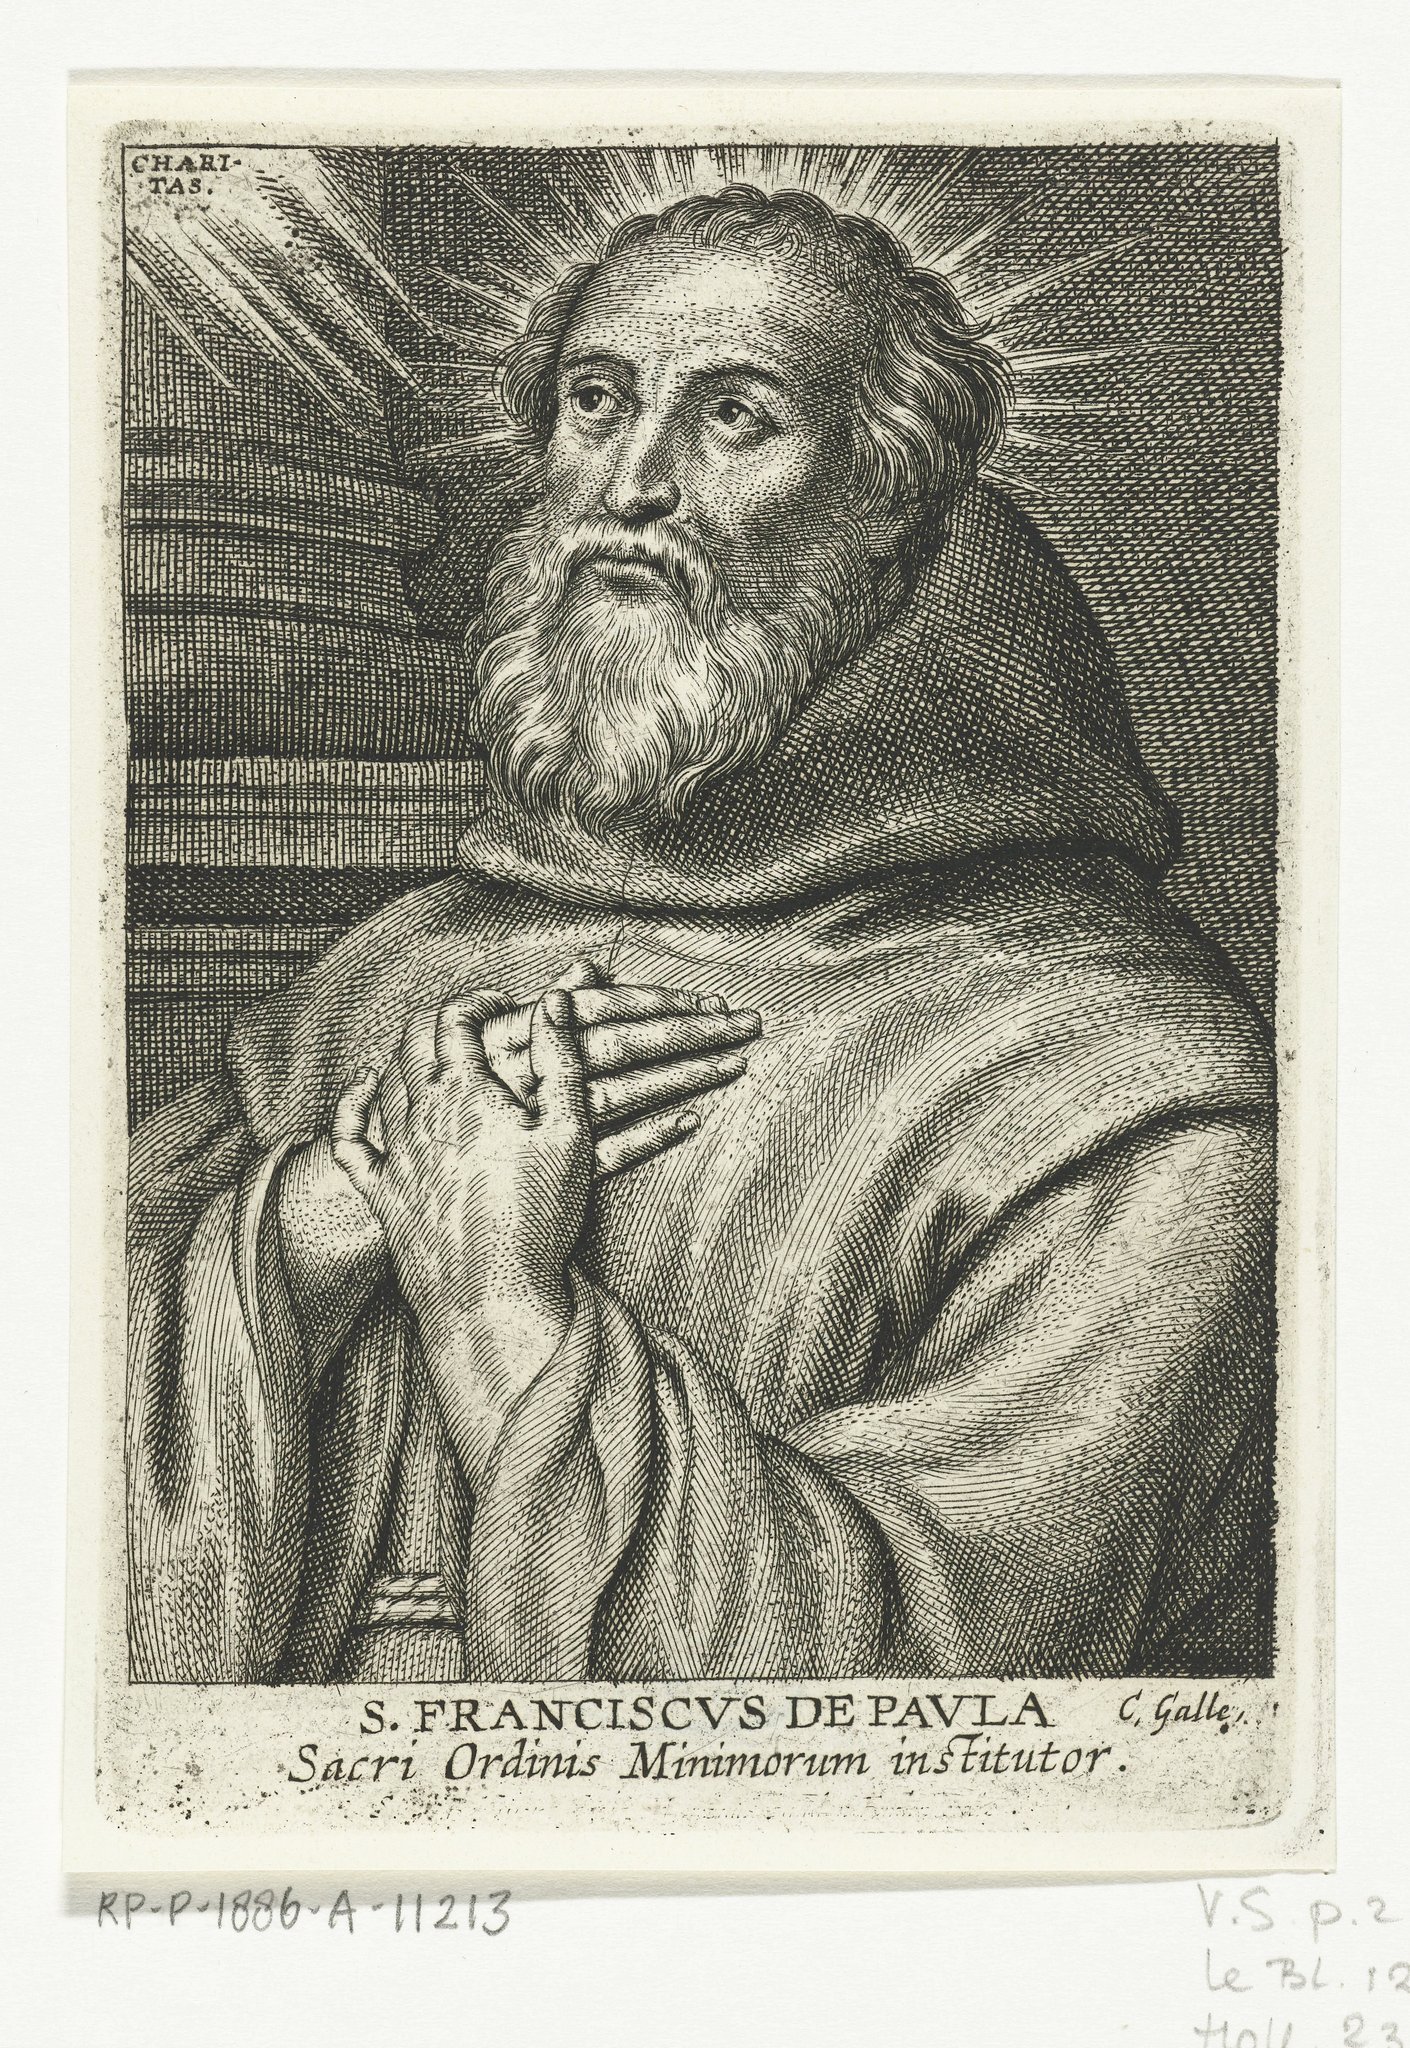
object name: print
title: Heilige Franciscus van Paula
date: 1596-1678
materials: paper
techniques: engraving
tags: the hermit and founder of the (franciscan) minim friars, francis of paola; possible attributes: inscription 'charitas' on breast, discipline, skull, staff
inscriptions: collector's mark: Lugt 2228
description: Prent naar ontwerp van Peter Paul Rubens.